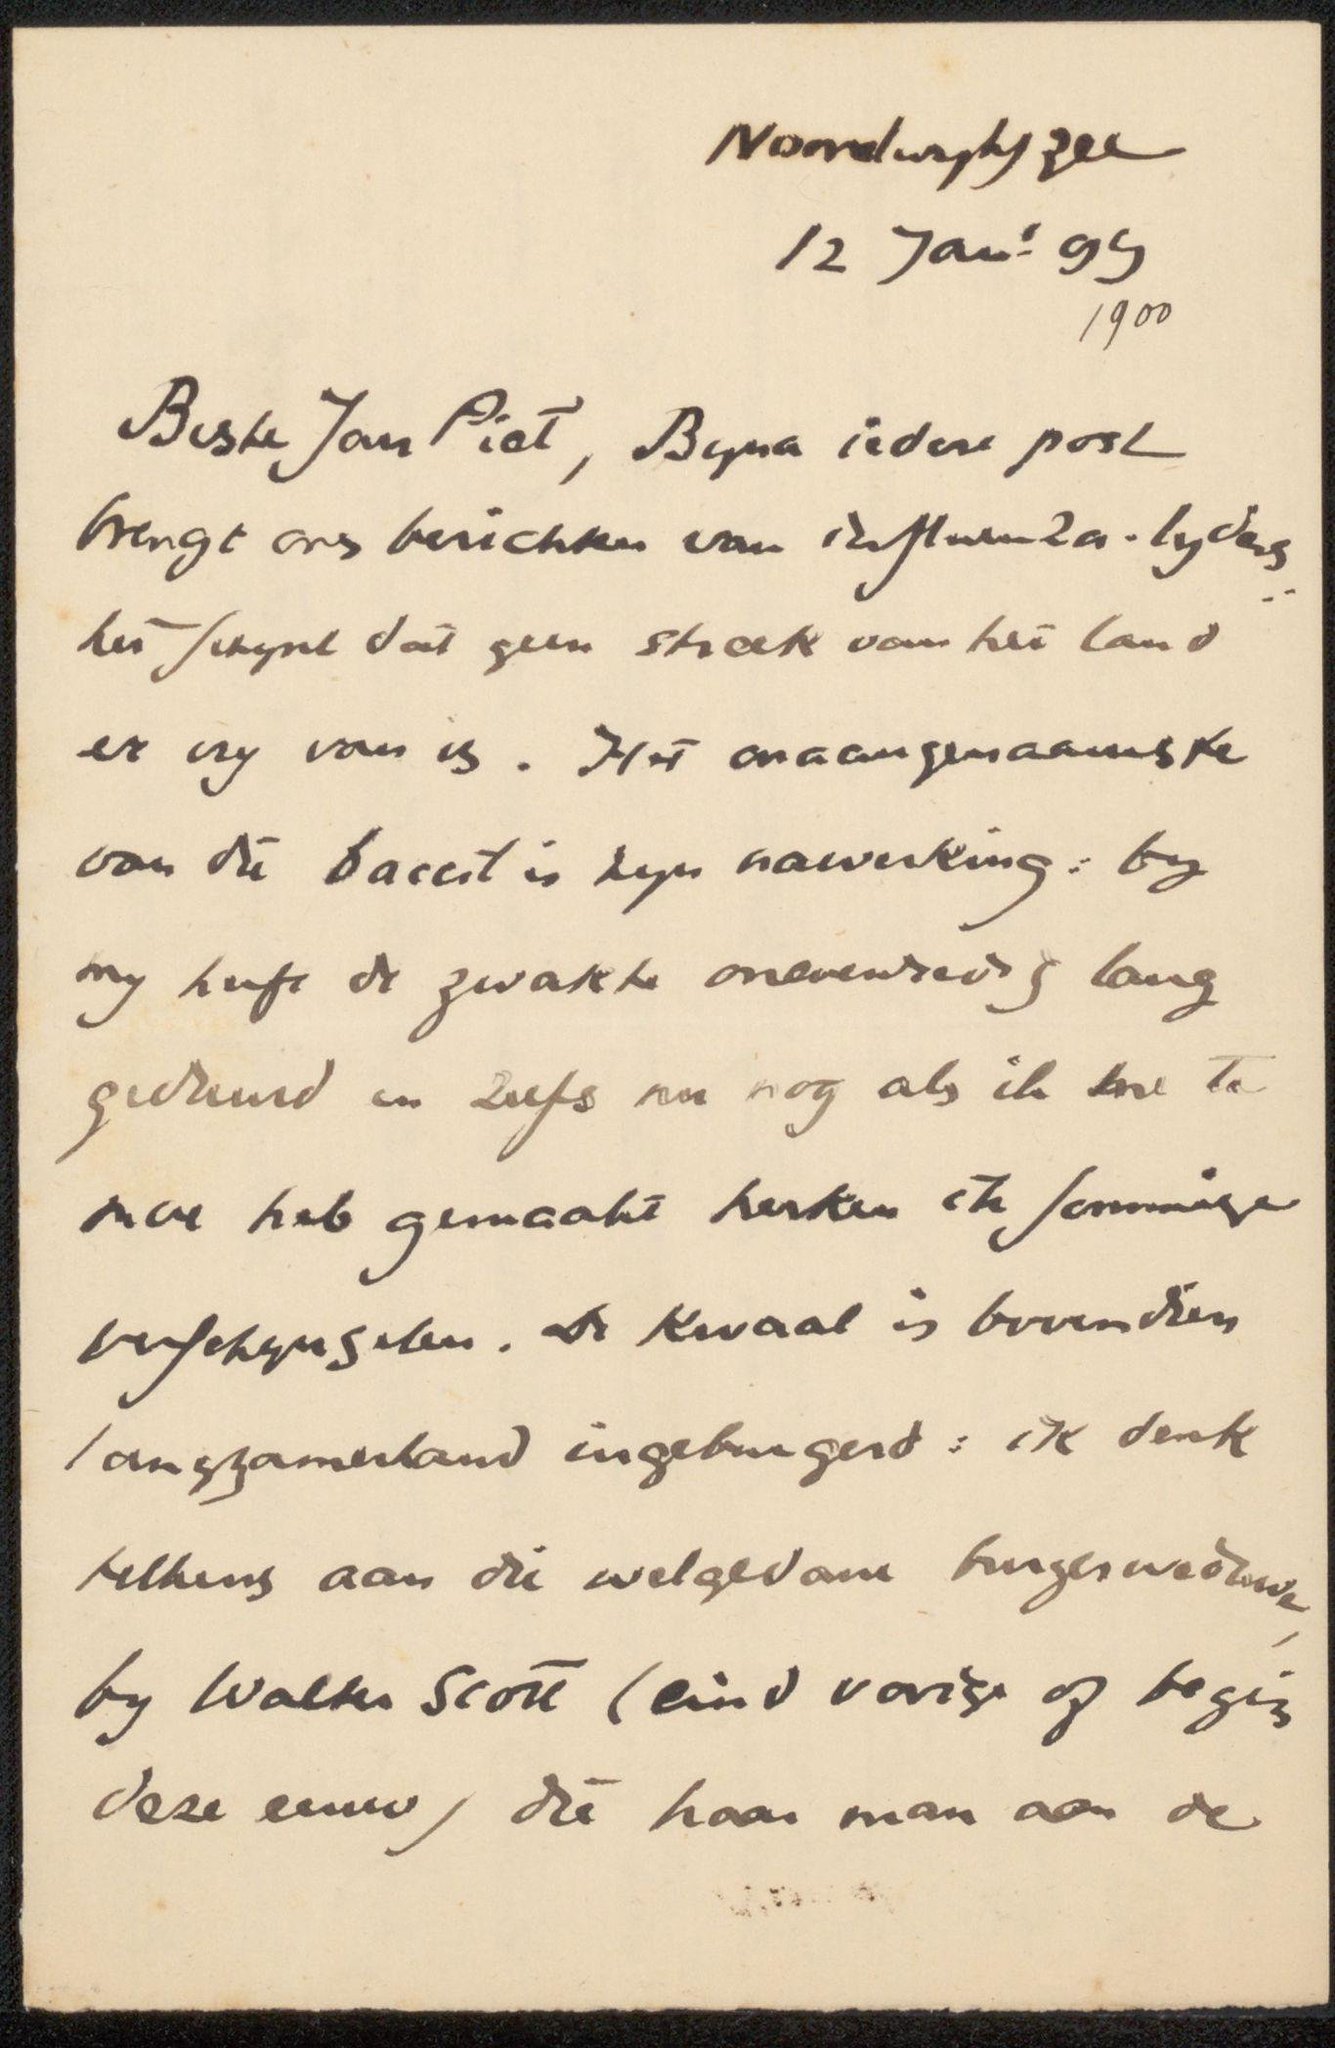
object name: letter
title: Brief aan Jan Veth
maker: albert verwey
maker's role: criticus, dichter, essayist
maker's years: 1865-1937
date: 1899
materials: ink, paper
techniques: pen, writing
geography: noordwijk aan zee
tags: dordrecht, painter, draughtsman, designer, jan veth, walter scott, literature ~ arts, diseases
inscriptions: collector's mark: ‘RPK’, watermark